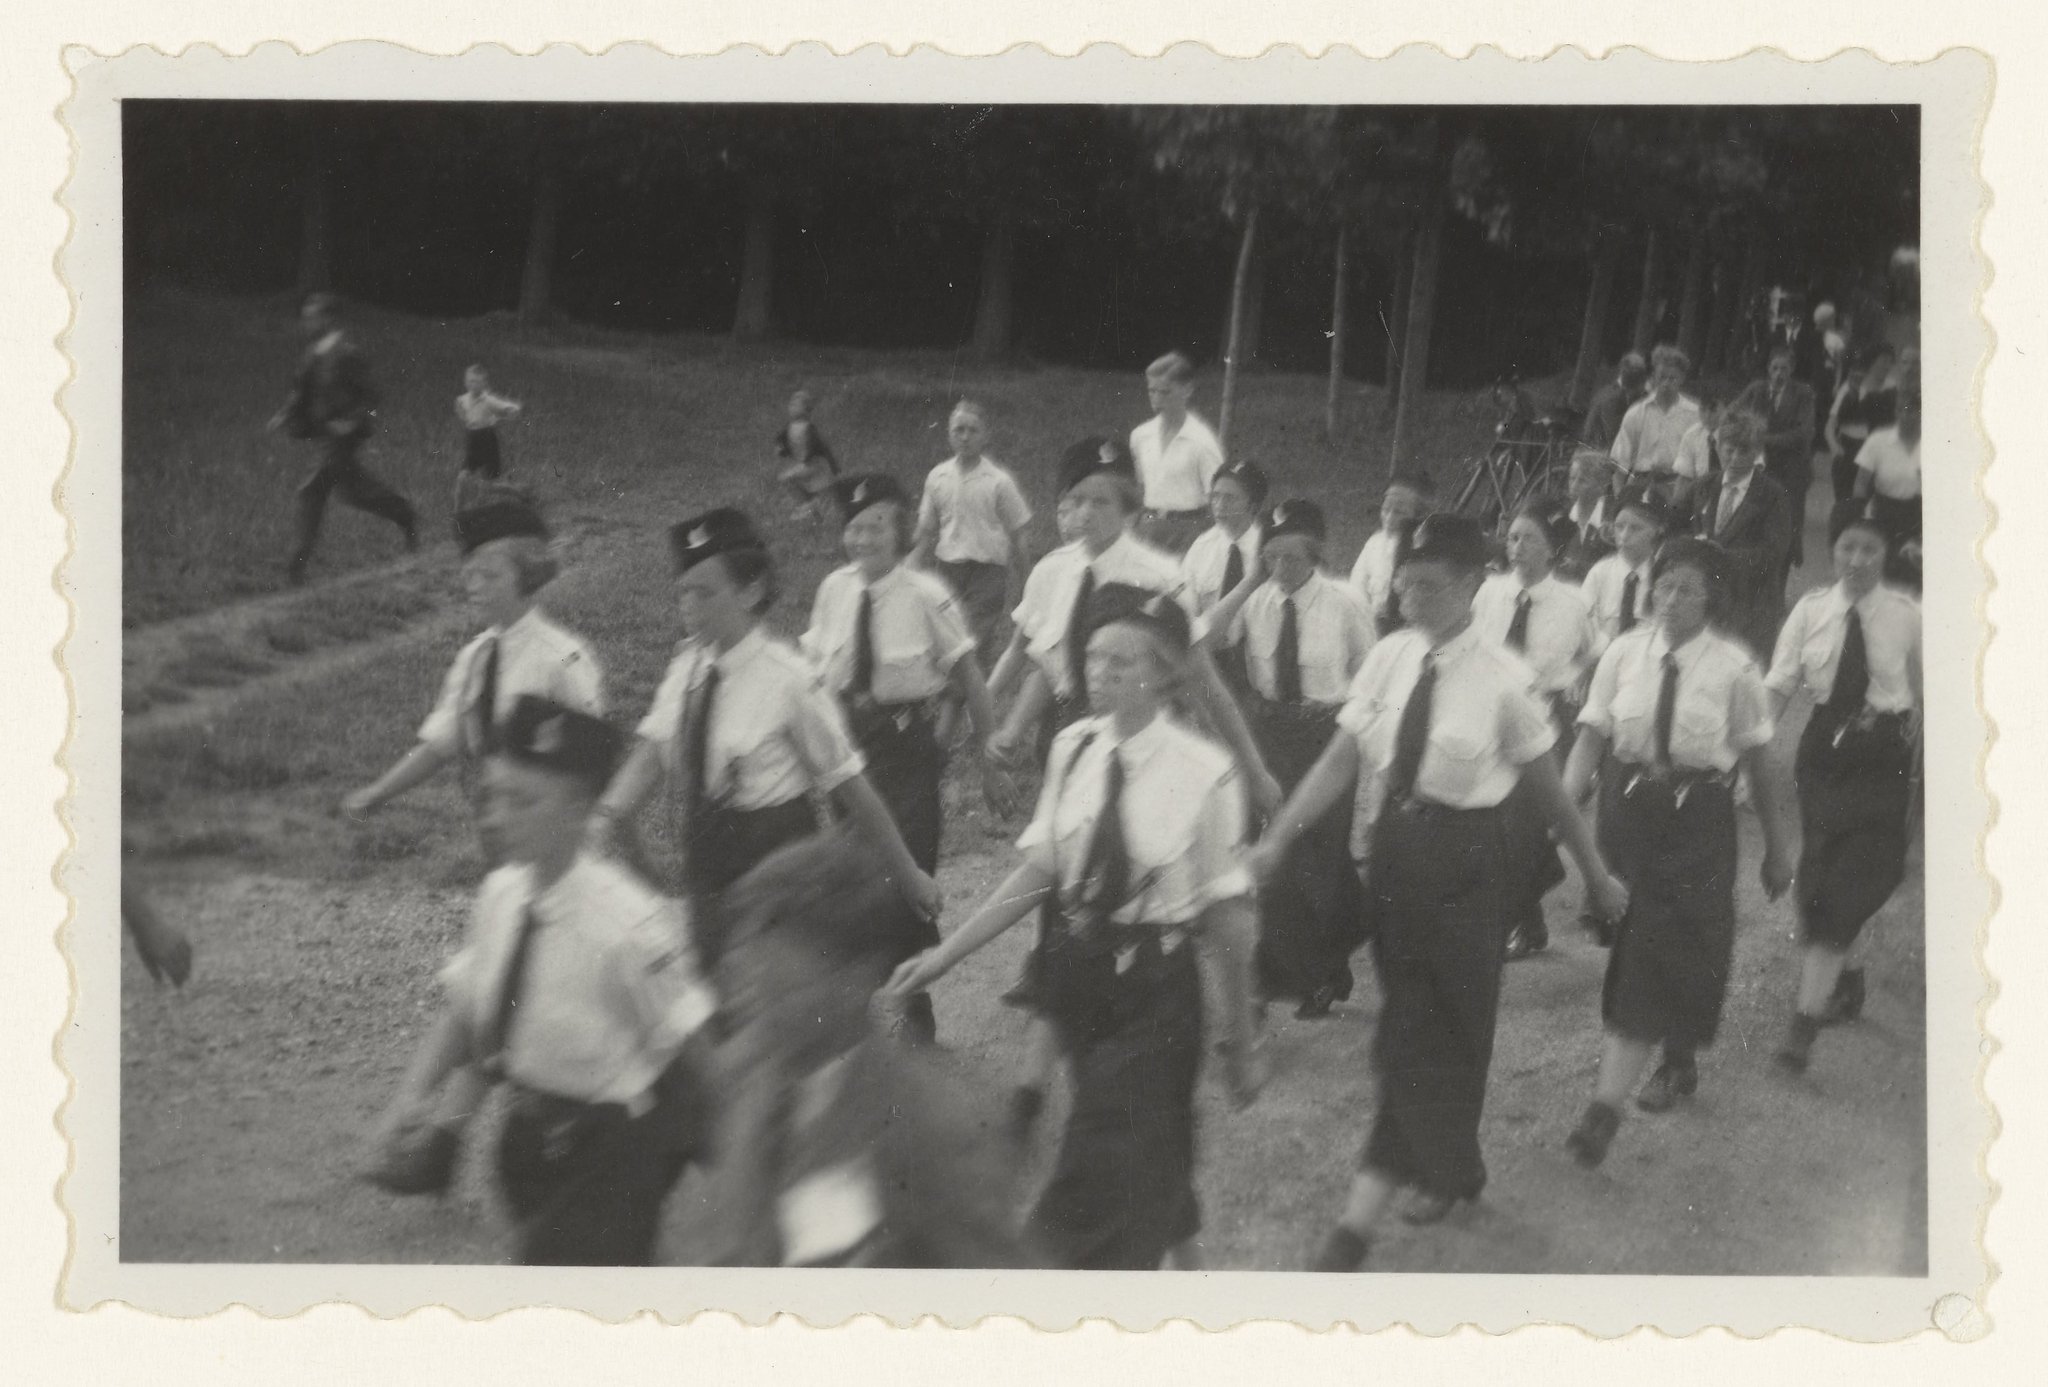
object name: photograph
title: Optocht Jeugdstorm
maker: Anonymous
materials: photographic support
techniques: photography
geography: utrecht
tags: military instruction, utrecht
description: Een optocht van de Jeugdstorm. Vooraan lopen vooral vrouwen in uniform, Stormsters, daarachter jongens met fietsen. De stoet loopt door het Wilhelminapark?